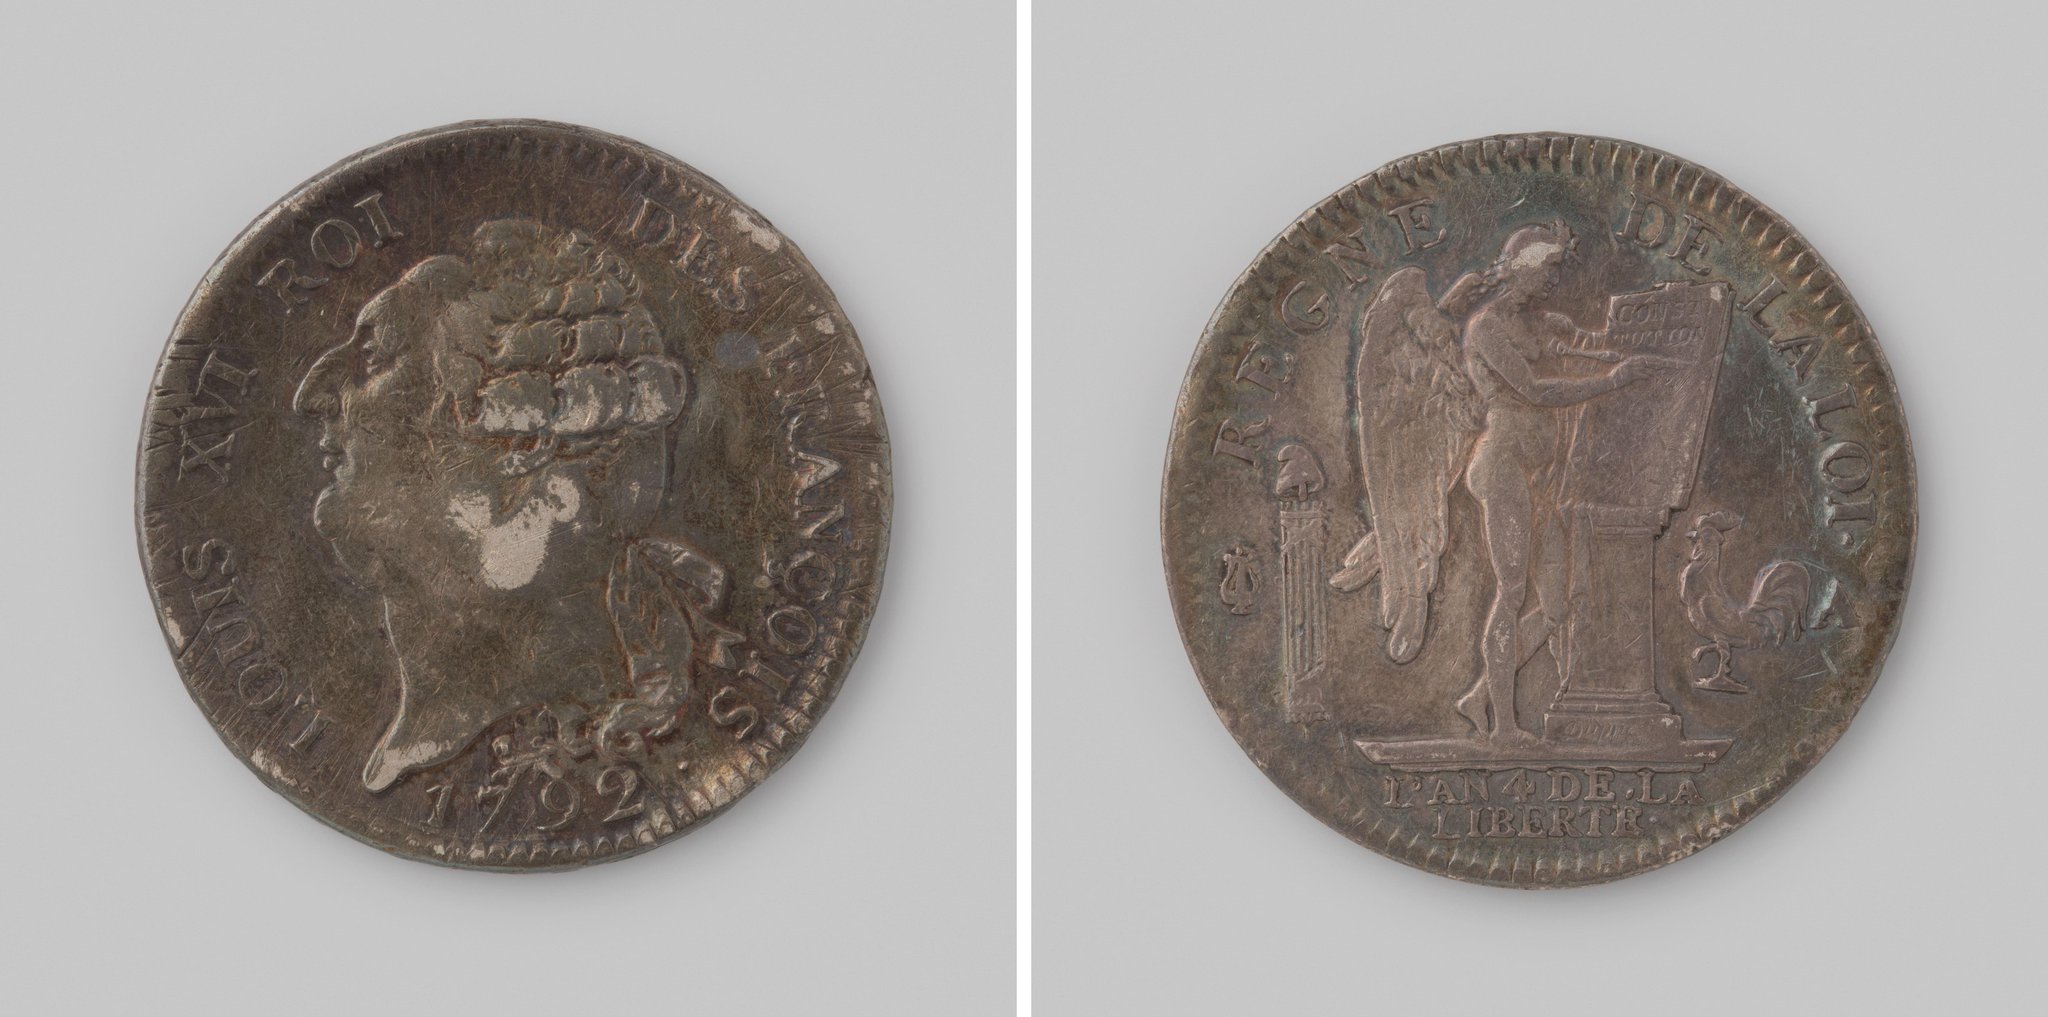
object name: coin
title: Ecu of 6 livres uit Frankrijk van Lodewijk XVI, 1792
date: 1792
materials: silver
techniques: striking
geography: paris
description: Zilveren munt. Voorzijde: borstbeeld van de koning naar links. Daaronder jaartal. Keerzijde: gevleugelde jongeling naar rechts die op een op voetstuk staand bord in twee regels schrijft: constitution. Links en rechts van hem attributen. In afsnede jaartal 4 in nieuwe telling. Uiterst rechts de letter A [=Parijs]. Randschrift.